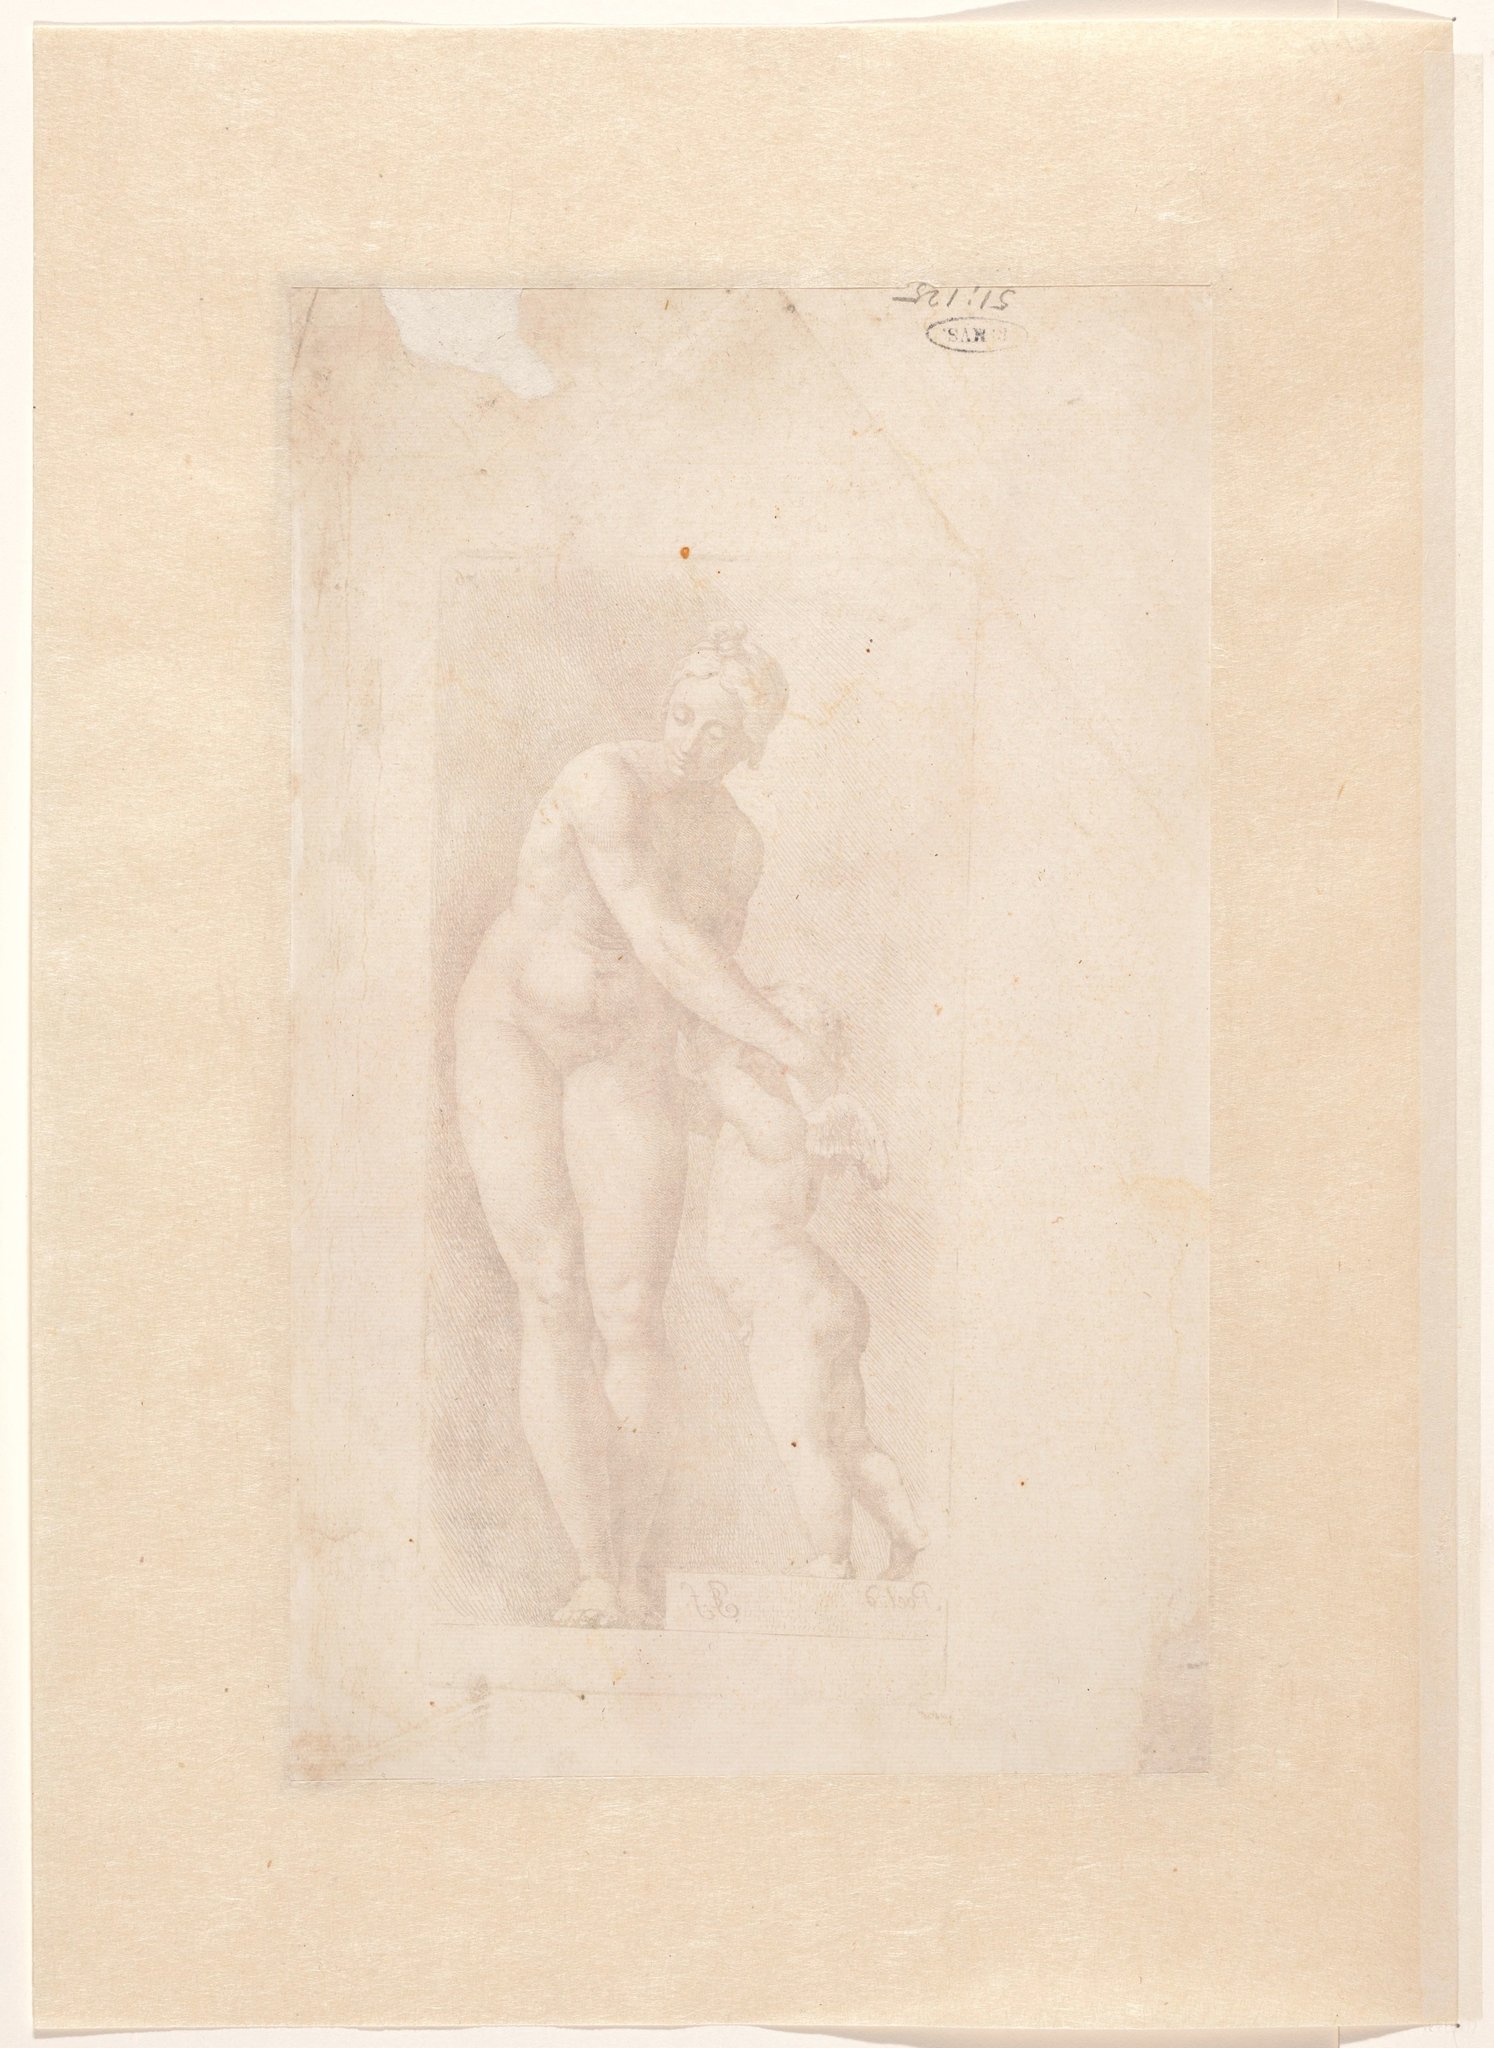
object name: print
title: Beeldengroep van Venus en Cupido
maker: jan de bisschop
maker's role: draughtsman, print maker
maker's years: 1628-1671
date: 1638-1771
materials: paper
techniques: printmaking, etching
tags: piece of sculpture, reproduction of a piece of sculpture, venus and cupid (cupid not being mere attribute)